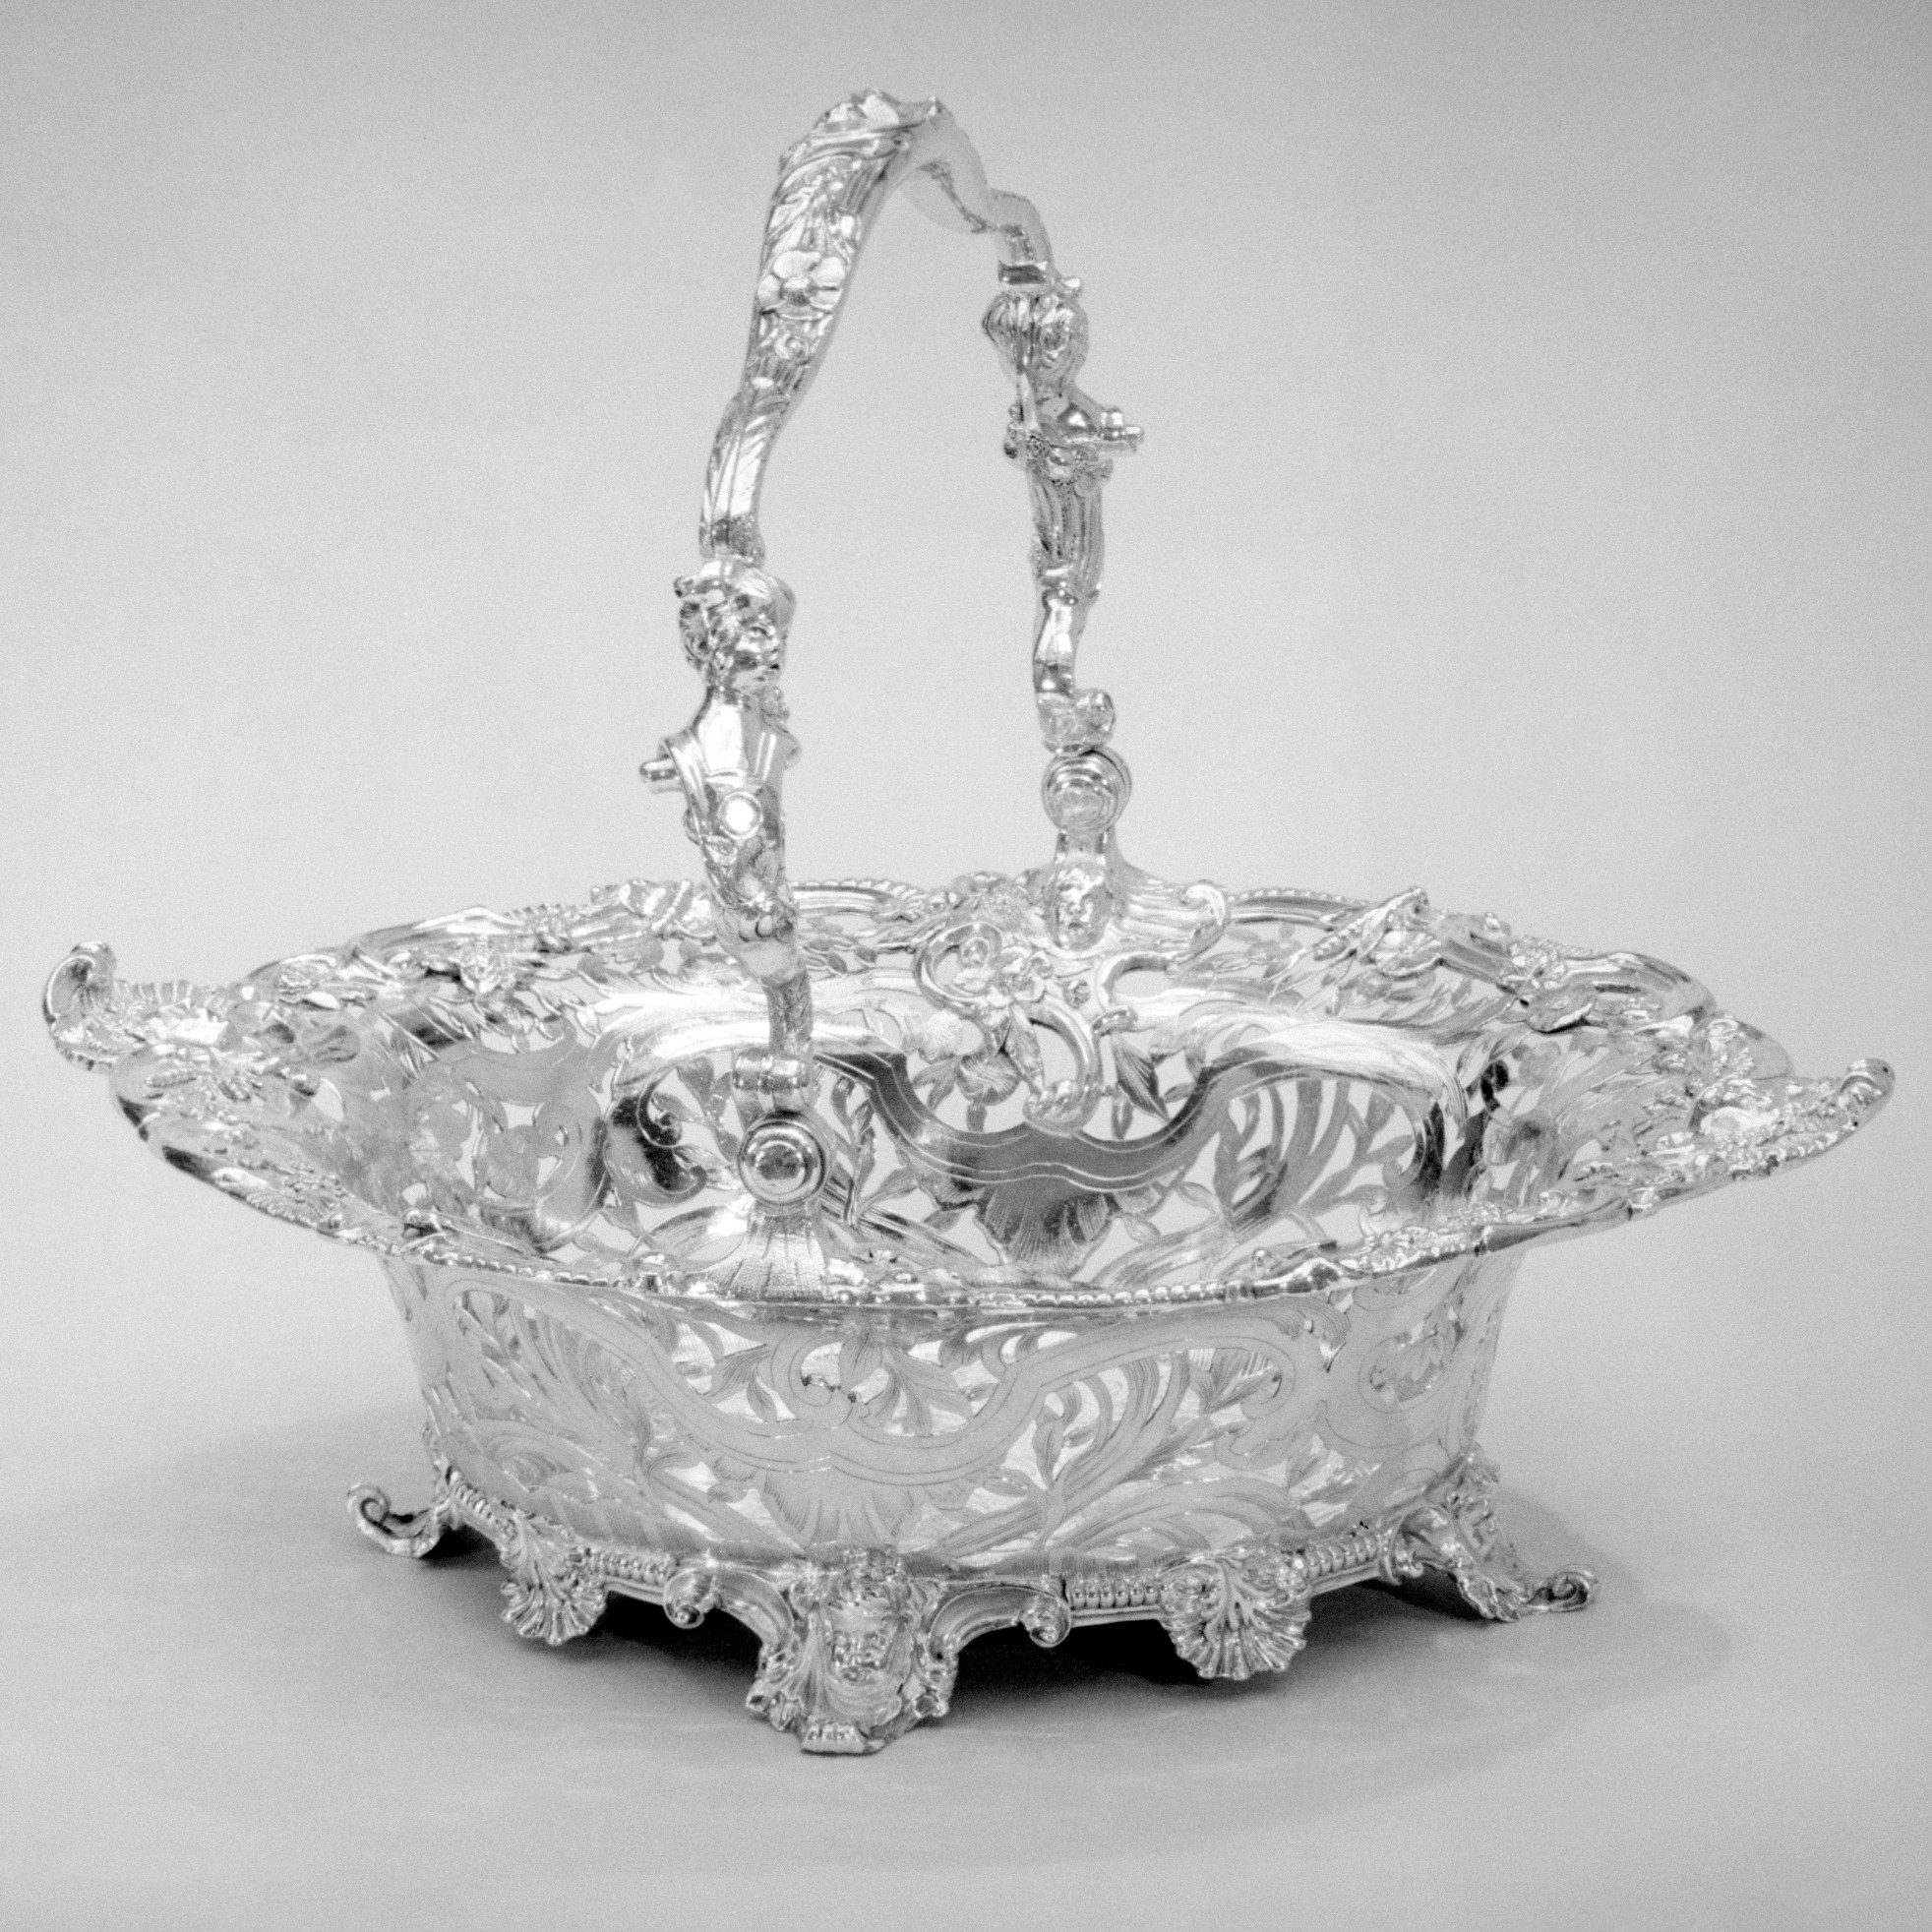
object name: cake basket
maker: paul de lamerie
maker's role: maker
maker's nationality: british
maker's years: 1688-1751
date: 1744-1745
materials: silver